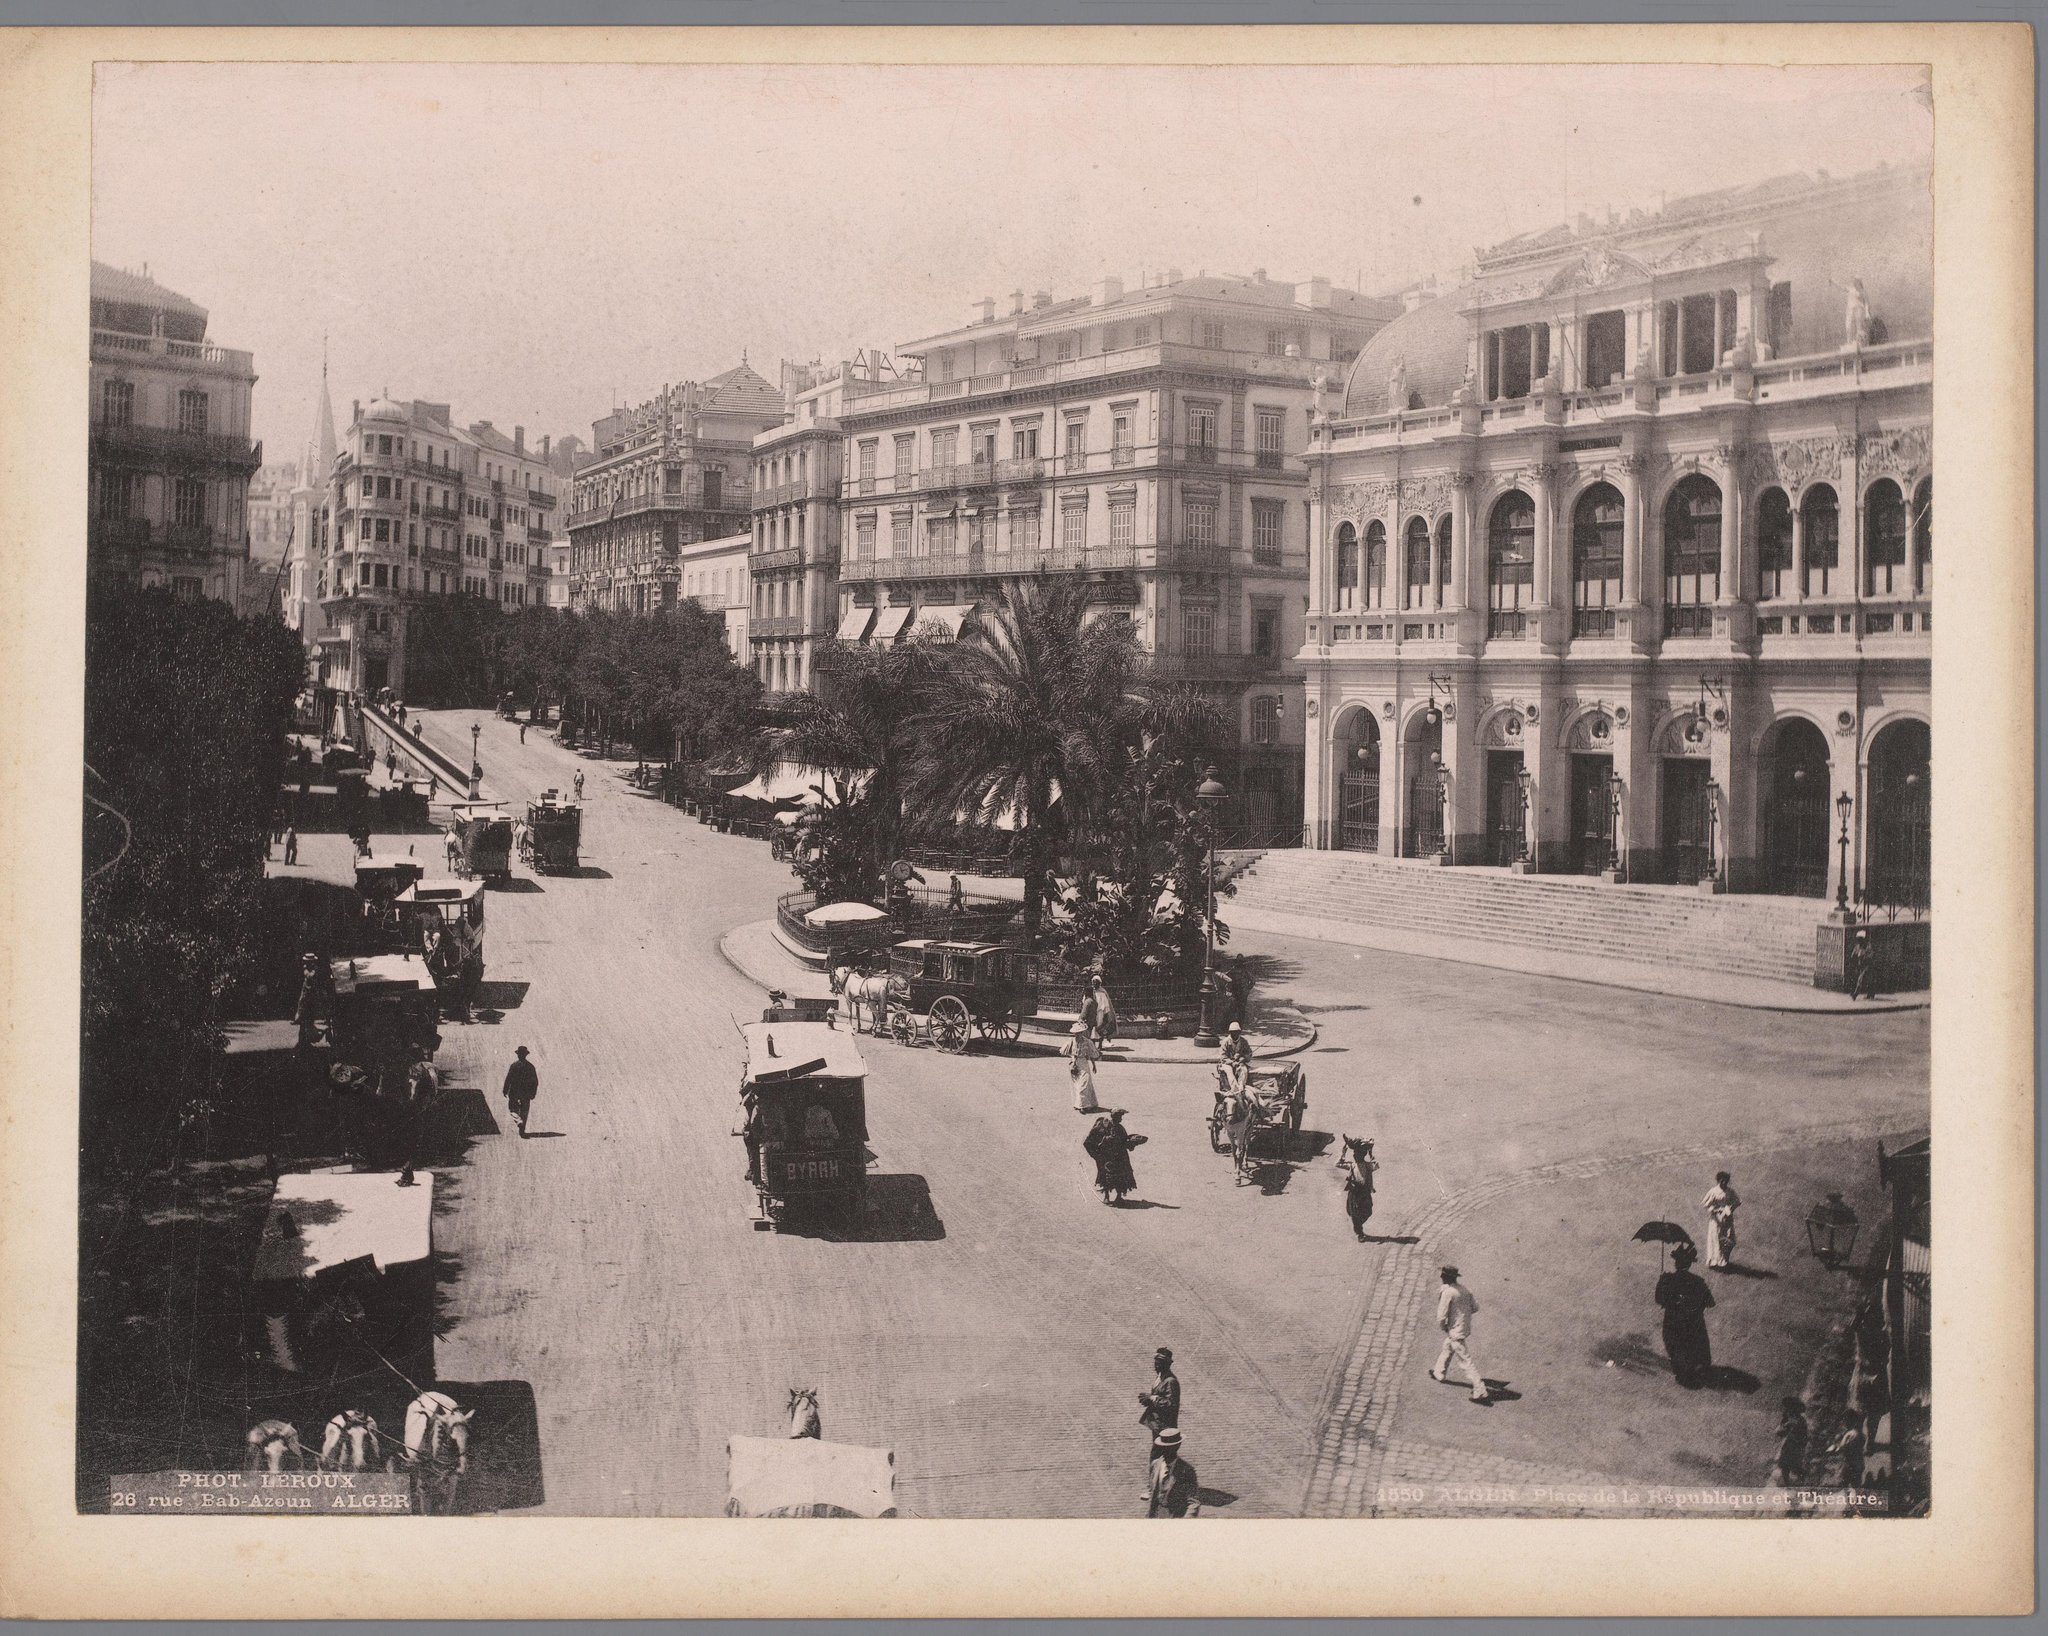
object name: photomechanical print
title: Alger, Place de la République et Théatre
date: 1875-1900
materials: cardboard, paper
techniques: photograph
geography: algiers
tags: théâtre national algérien mahieddine bachtarzi, place de la république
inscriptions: number: ‘1550’, address: ‘26 rue Bab-Azoun ALGER’